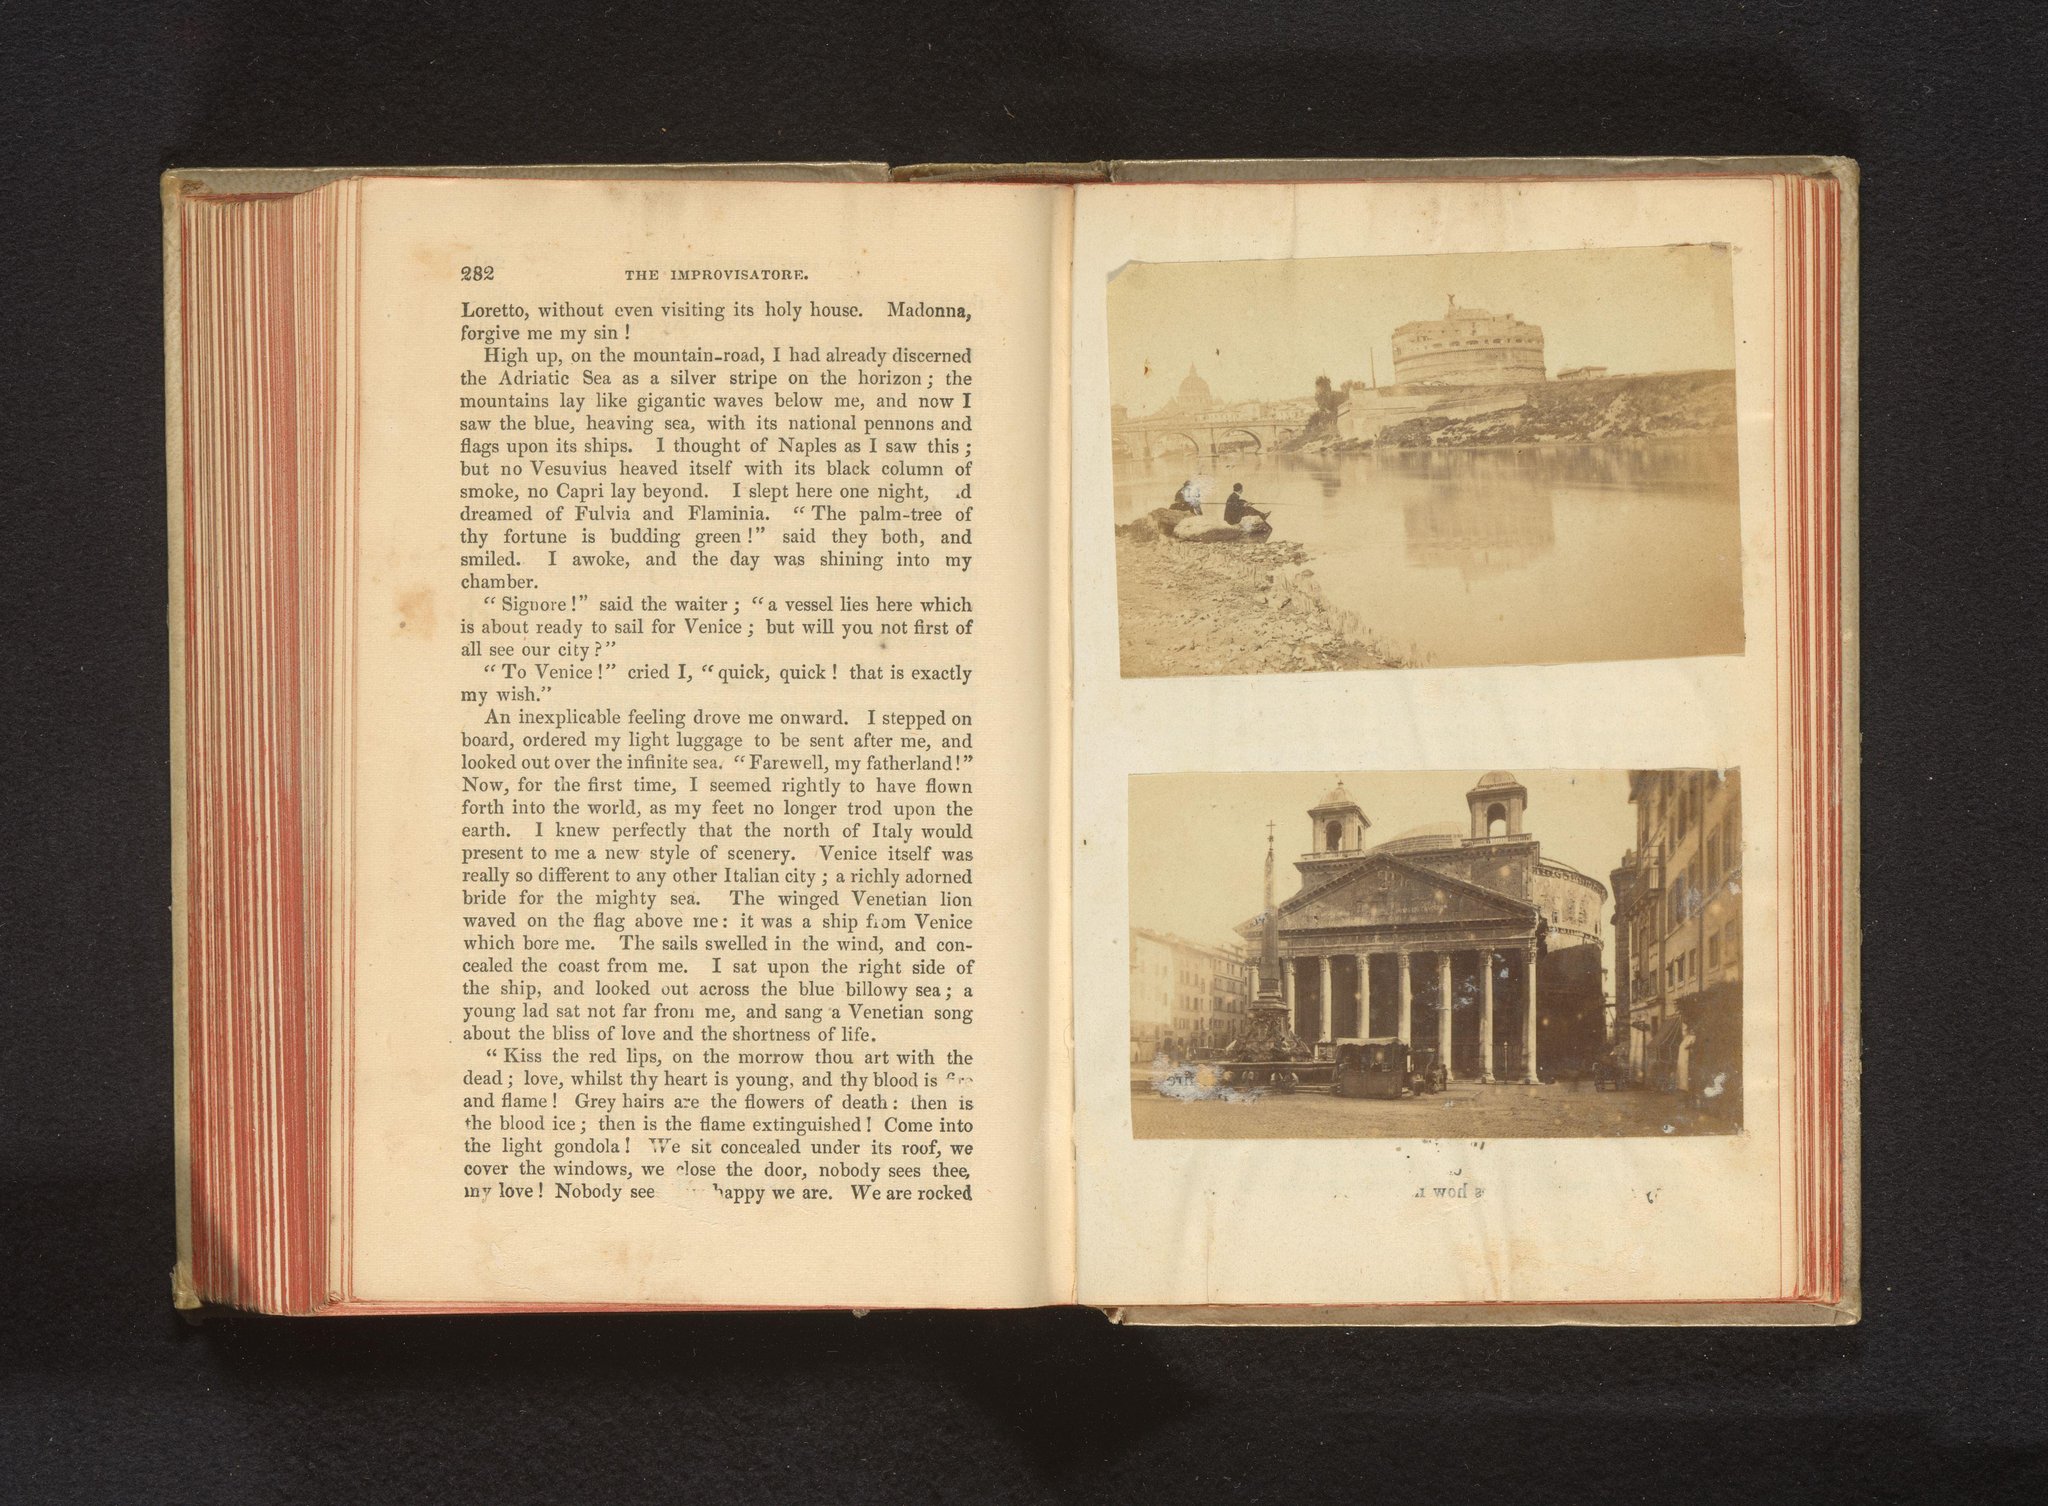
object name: photograph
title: Gezicht op de Tiber te Rome en de voorgevel van het Pantheon te Rome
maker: Anonymous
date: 1863-1873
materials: photographic support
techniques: albumen print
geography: rome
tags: river, church (exterior), façade (of house or building)